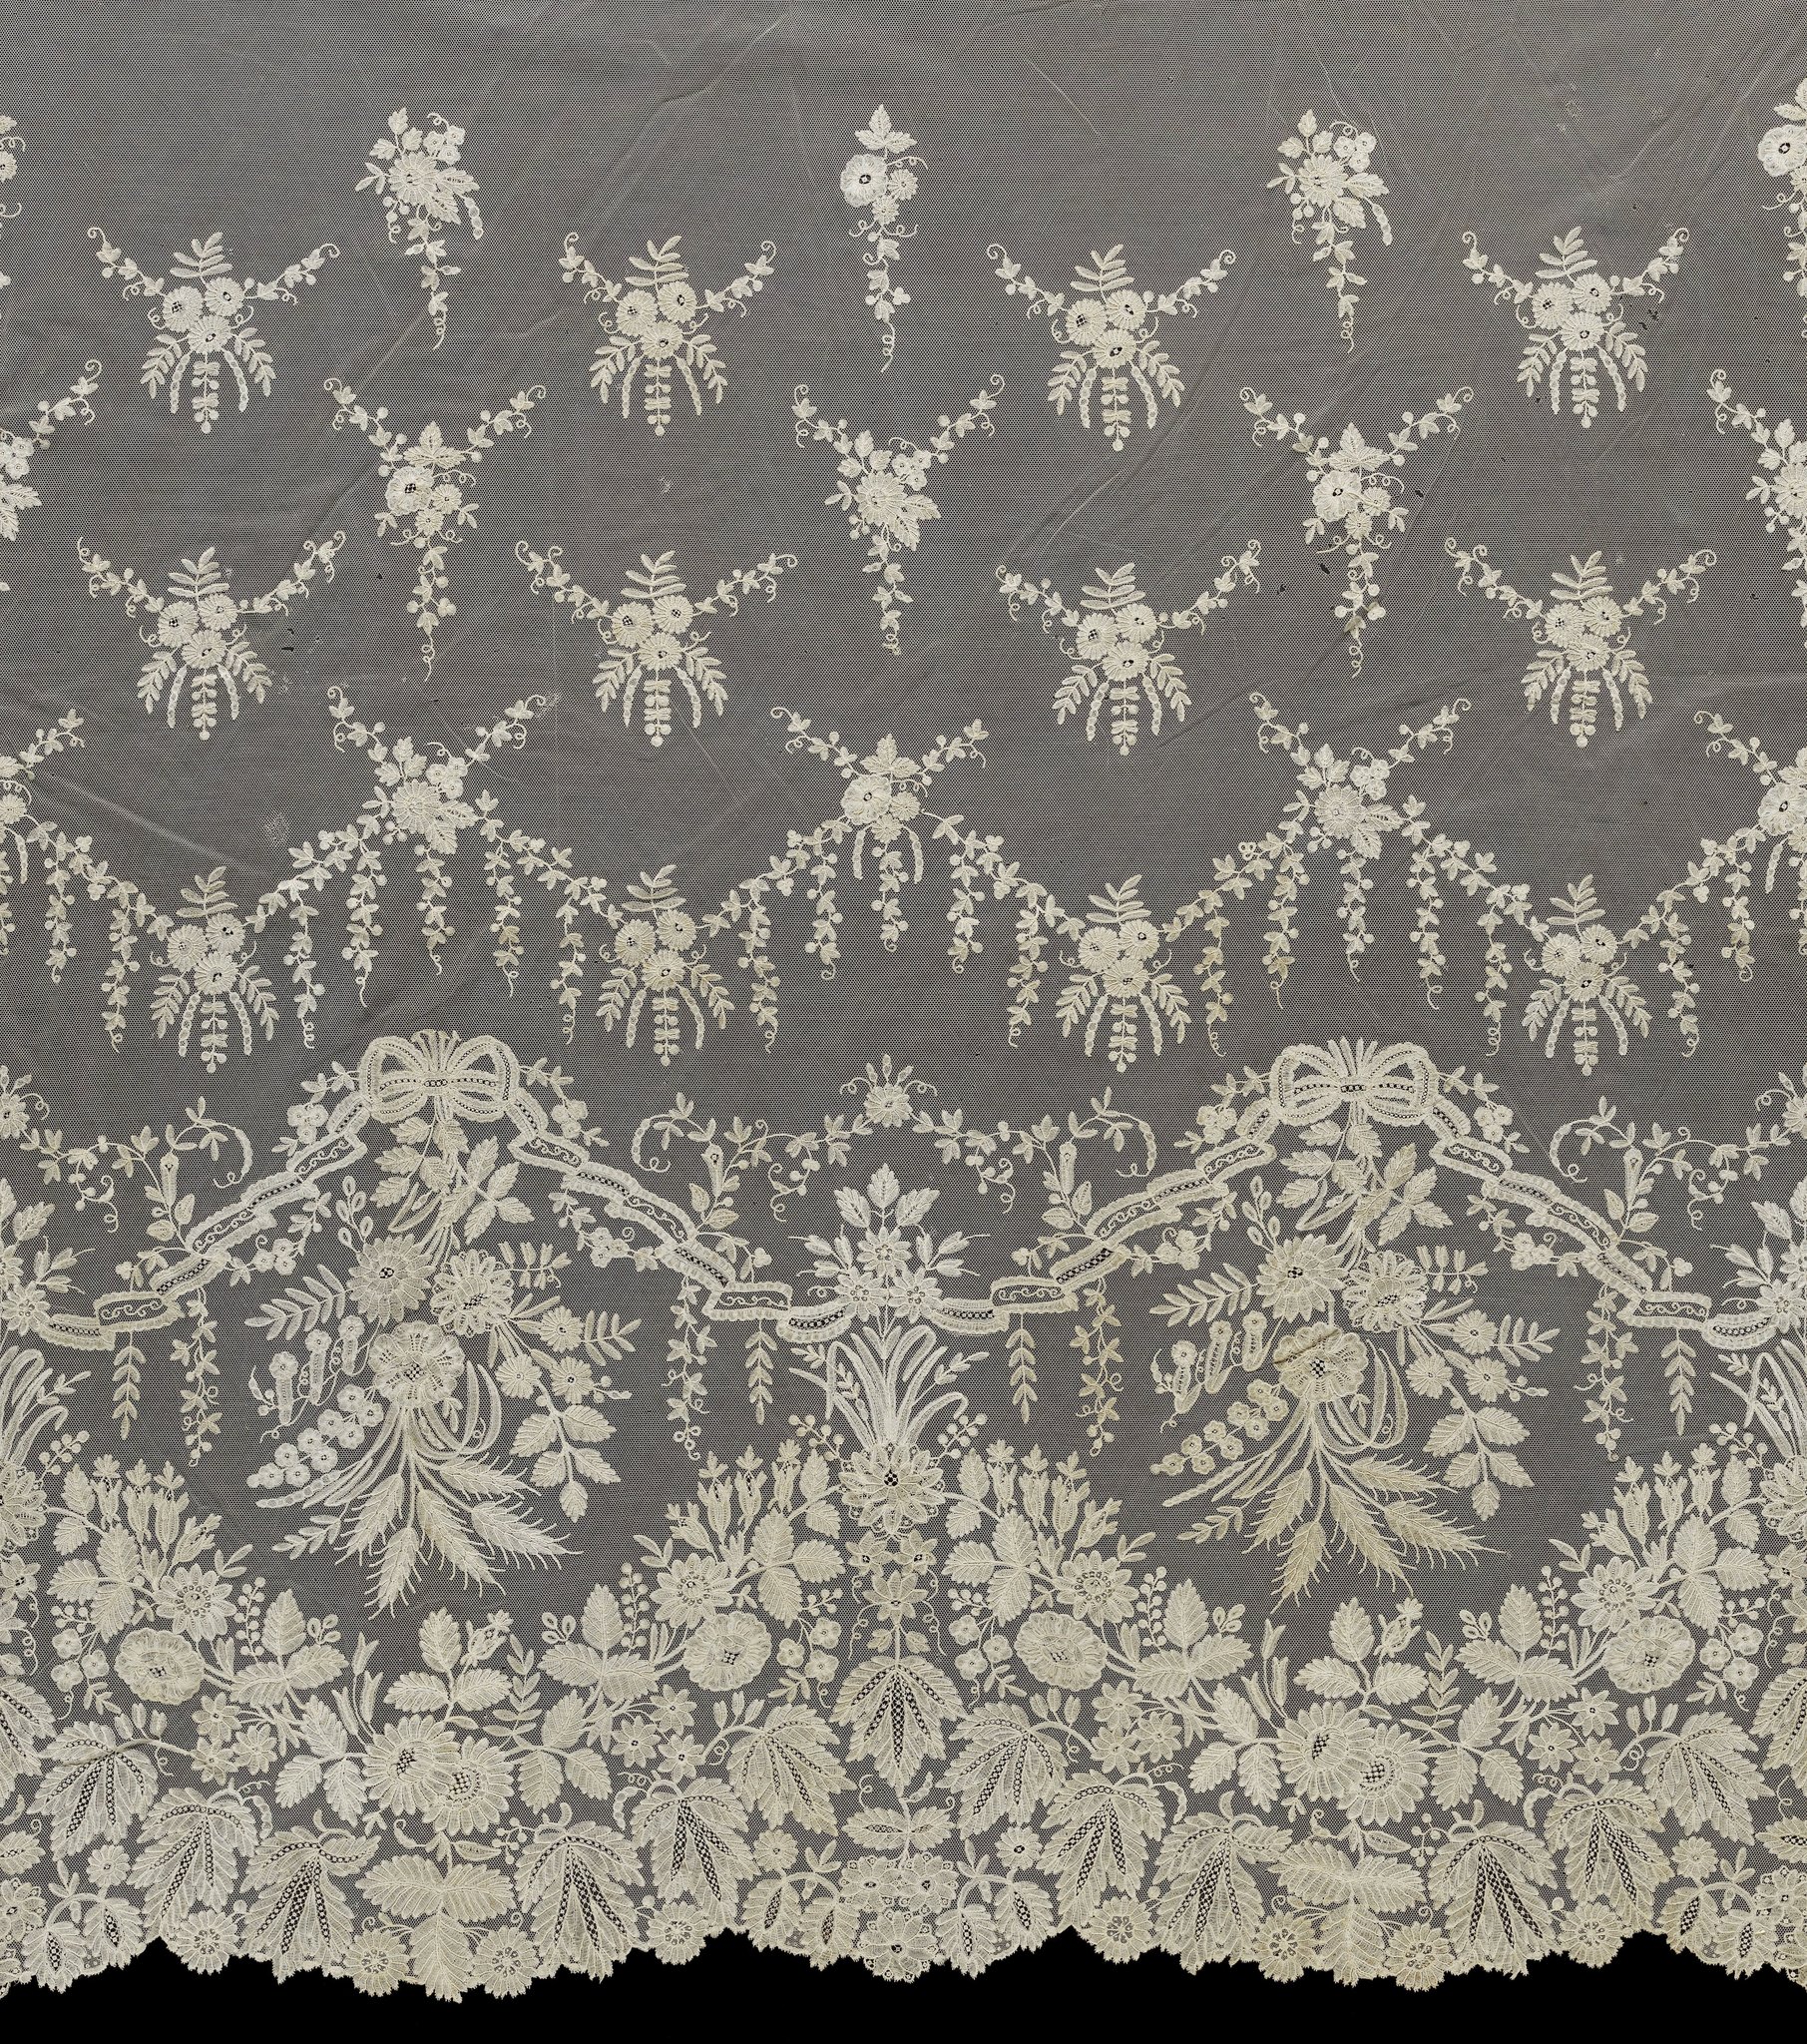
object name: overskirt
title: Overrok van een bruidskleed van applicatiekant met veldboeketten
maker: Anonymous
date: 1900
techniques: lace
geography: brussels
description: Overrok van naturelkleurige applicatiekant: kloskant met naaldkant siersteken - Brusselse duchesse - geappliceerd op machinale tule. Rondlopend recht model, zonder naad. De overrok hoort bij een kanten bruidskleed. Het patroon neemt van boven naar onder in dichtheid toe. Bovenaan de rok is een strooipatroon te zien van bloemtakken en korte bloemslingers. Onder het strooipatroon loopt een zigzaglijn, met vergelijkbare bloemen uit het strooipatroon. Onder de zigzaglijn een golvend, dubbel lint. Op elke golftop vormt het lint een strik, waaraan een groot veldboeket hangt. De veldboeketten worden afgewisseld door staande veldboeketten, die ontspringen uit de golftoppen van de bloemenrank langs de onderrand van de rok. Deze bloemenrank vertoont een rijke variëteit aan grote bloemen en bladeren. De schulpenrand langs de onderzijde van de rok wordt onder andere gevormd door grote wingerdbladeren en madeliefjes. De bovenkant is niet afgewerkt. Er zijn enkele metalen knoopjes bevestigd langs een splitje in de bovenkant.